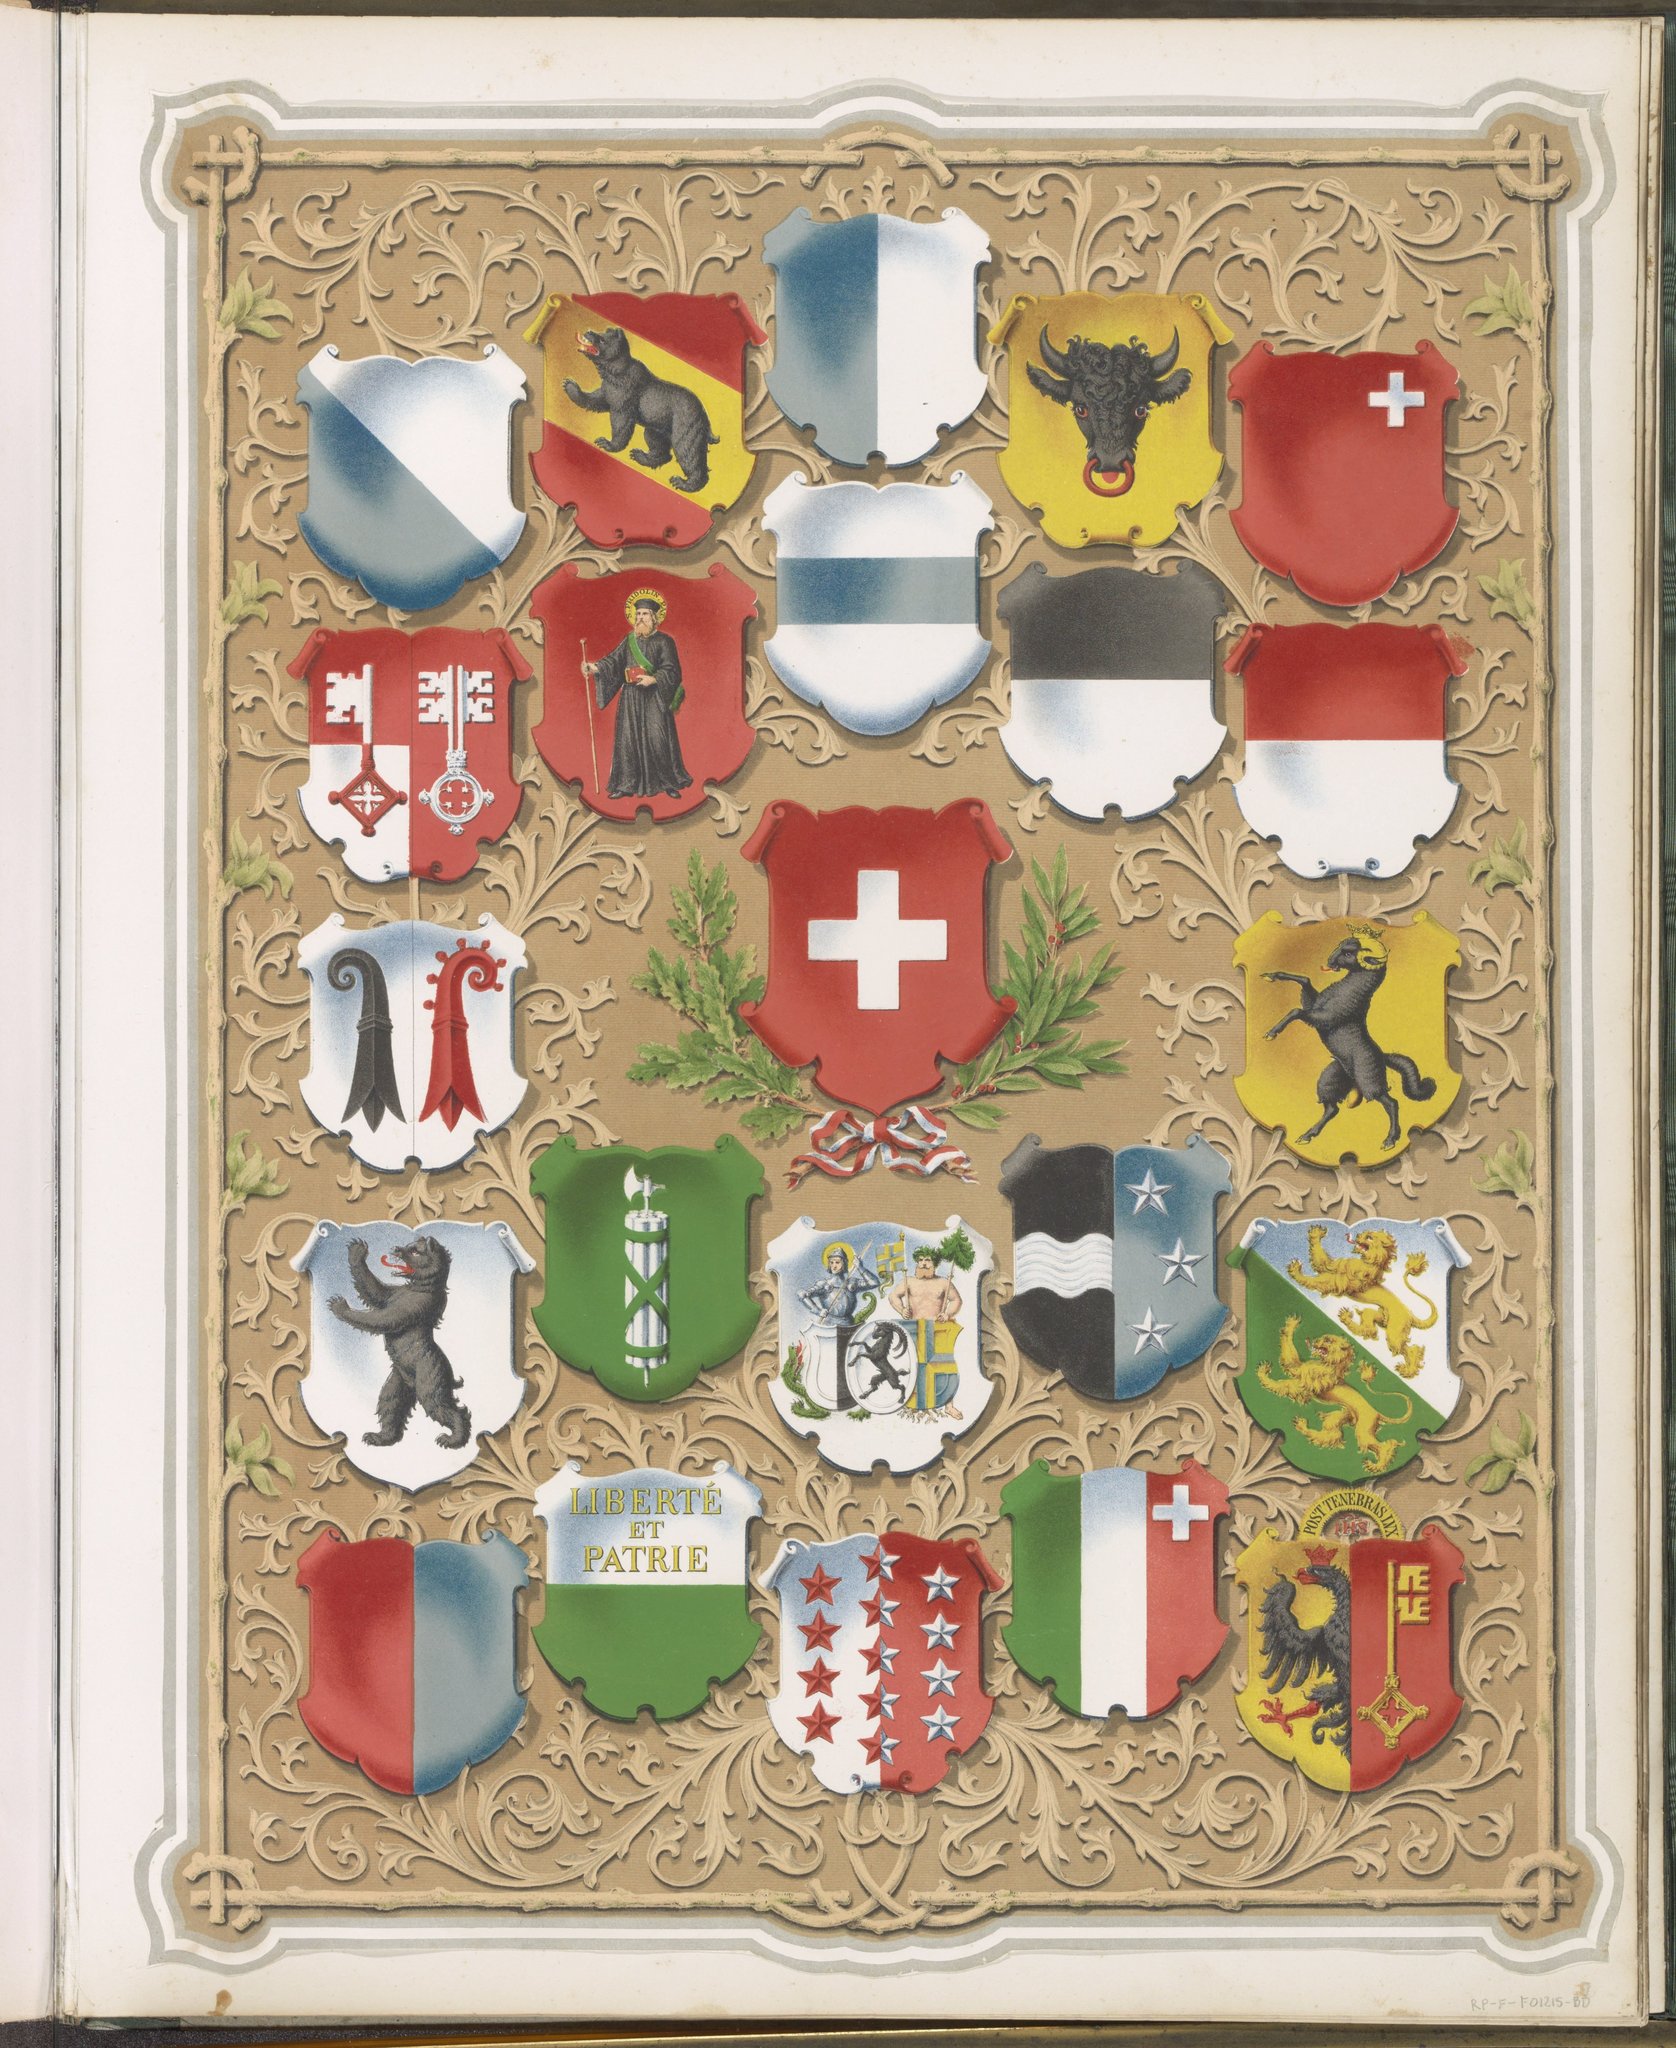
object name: print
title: Overzicht van wapenschilden van Zwitserland en 22 kantons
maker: Anonymous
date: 1850-1875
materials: paper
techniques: lithograph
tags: coat of arms (as symbol of the state, etc.)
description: Onderdeel van Reisalbum met opnames van kunstwerken, personen en bezienswaardigheden in Spanje.